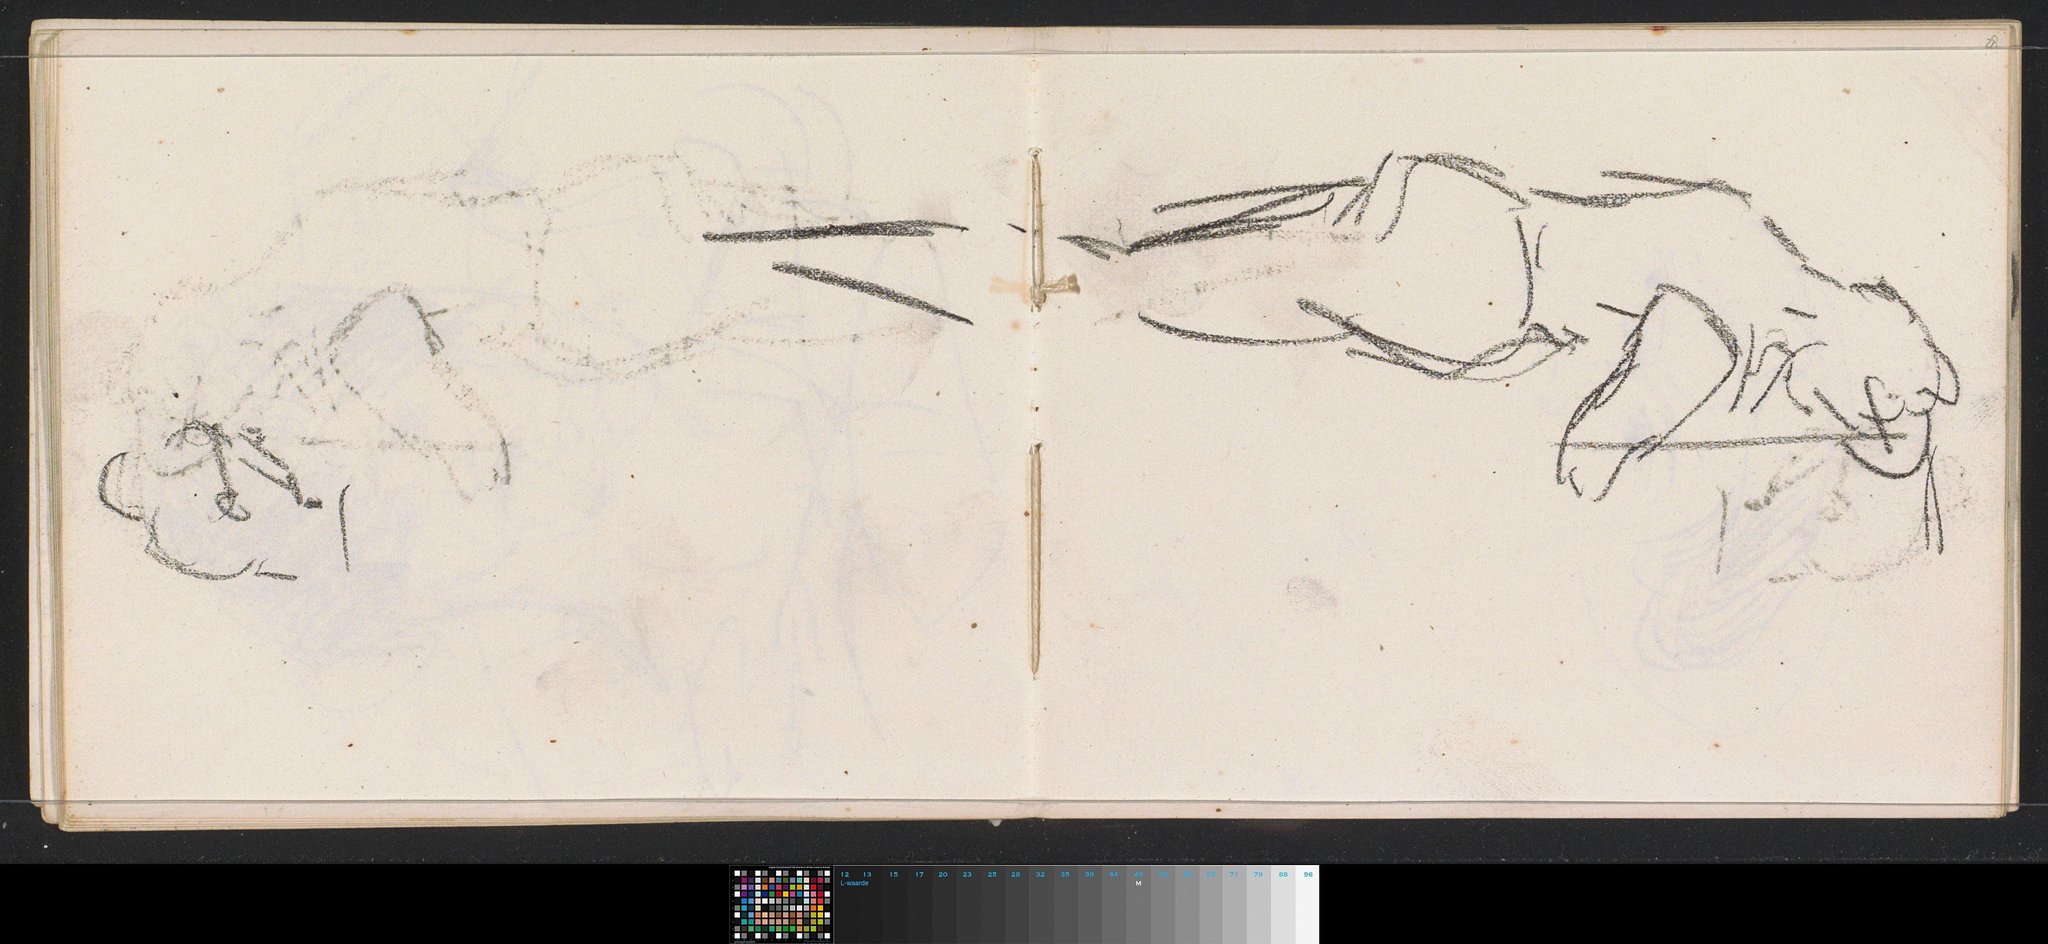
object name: sketchbook leaf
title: Vrouwenhoofd en een staande vrouw, in profiel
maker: isaac israels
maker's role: draughtsman, painter, print maker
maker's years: 1865-1934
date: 1875-1934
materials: chalk, paper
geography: the hague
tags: adult woman (+ standing), head (human) - aa - female human figure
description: Pagina 27 en pagina 28 uit schetsboek XLIII met 61 pagina's.